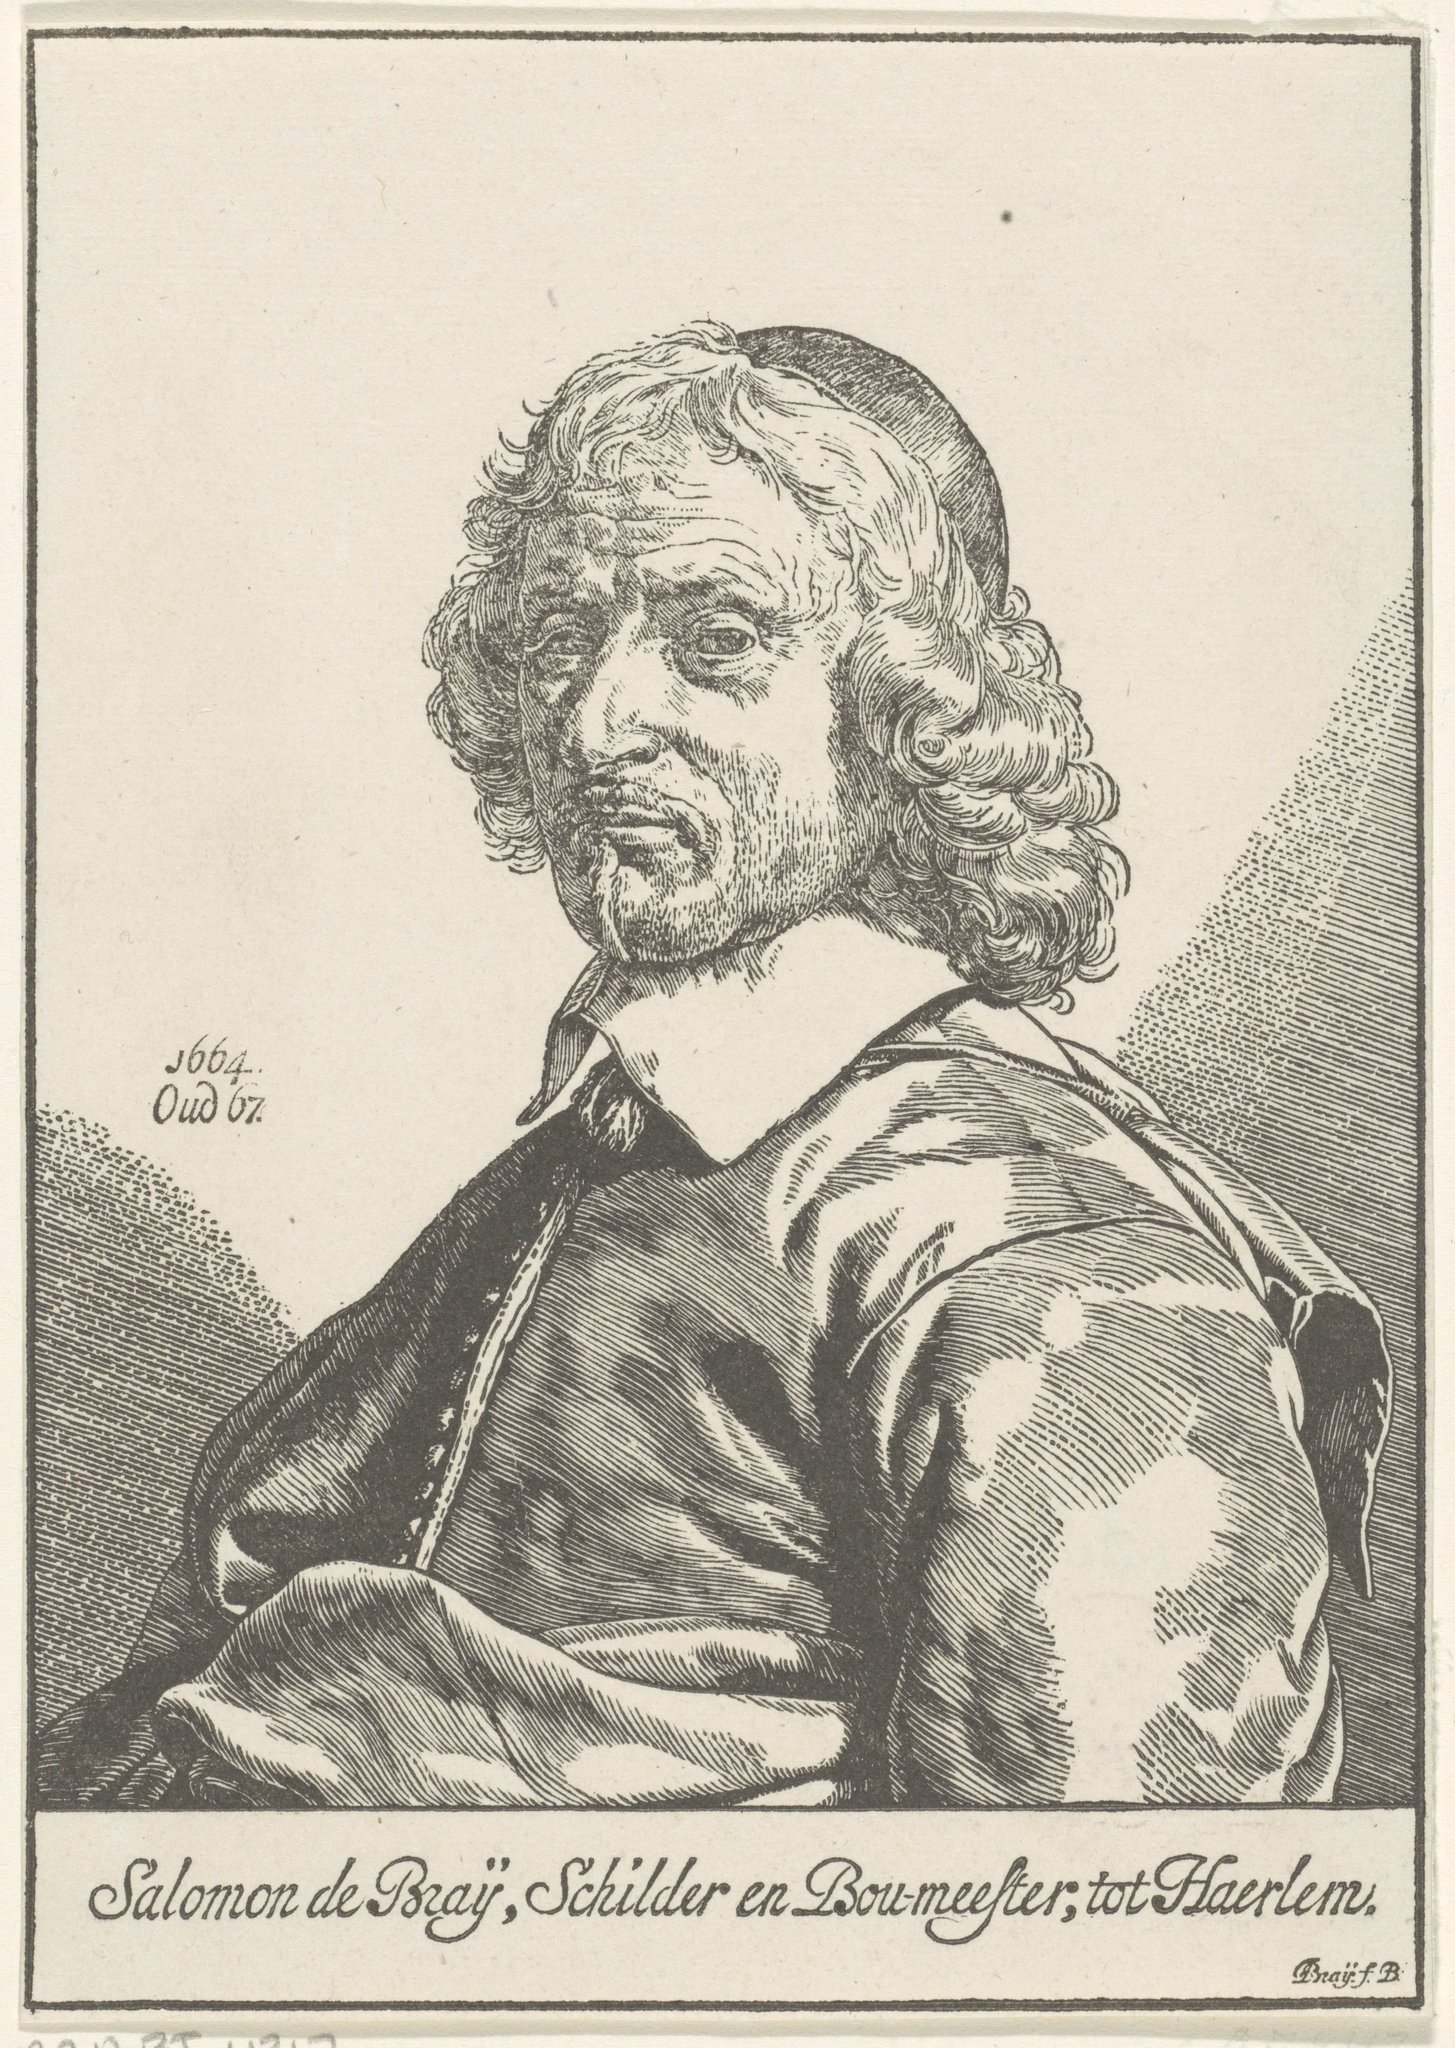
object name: print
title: Portret van Salomon de Bray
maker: dirck de bray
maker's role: draughtsman, painter, print maker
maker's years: 1625-1694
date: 1664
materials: paper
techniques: woodcut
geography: netherlands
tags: amsterdam, print maker, draughtsman, salomon de bray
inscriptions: collector's mark: Lugt 240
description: Portret van Salomon de Bray. In een kader zijn naam en beroep.